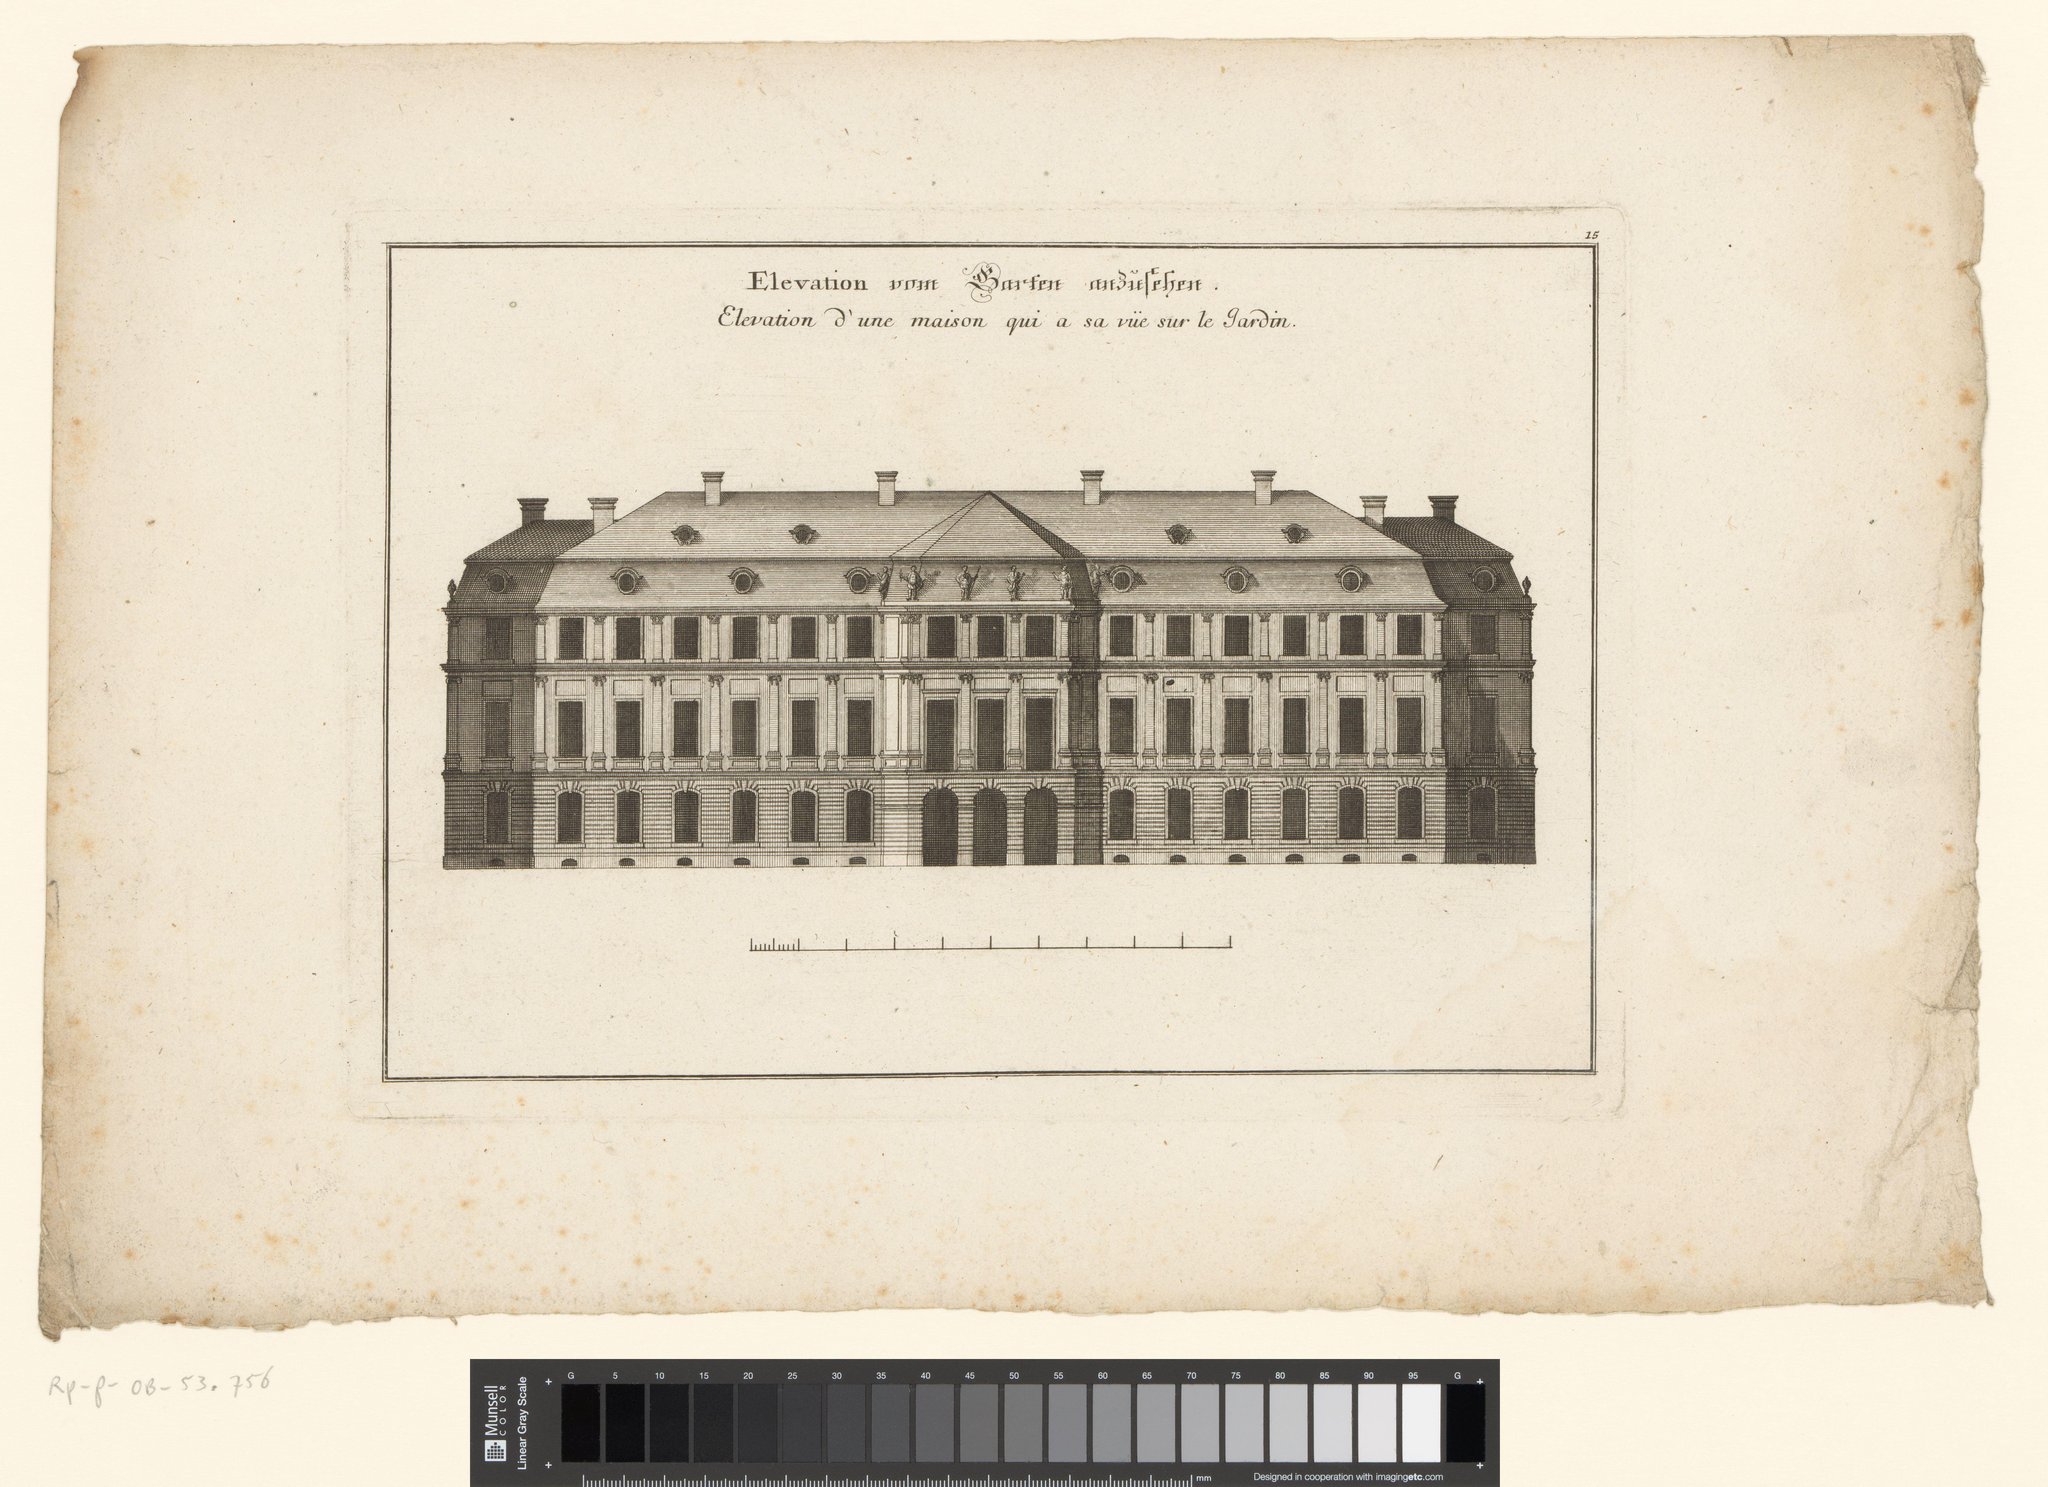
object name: print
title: Architecture Civile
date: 1750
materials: paper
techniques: engraving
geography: augsburg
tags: civic architecture; edifices; dwellings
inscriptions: collector's mark: Lugt 2228